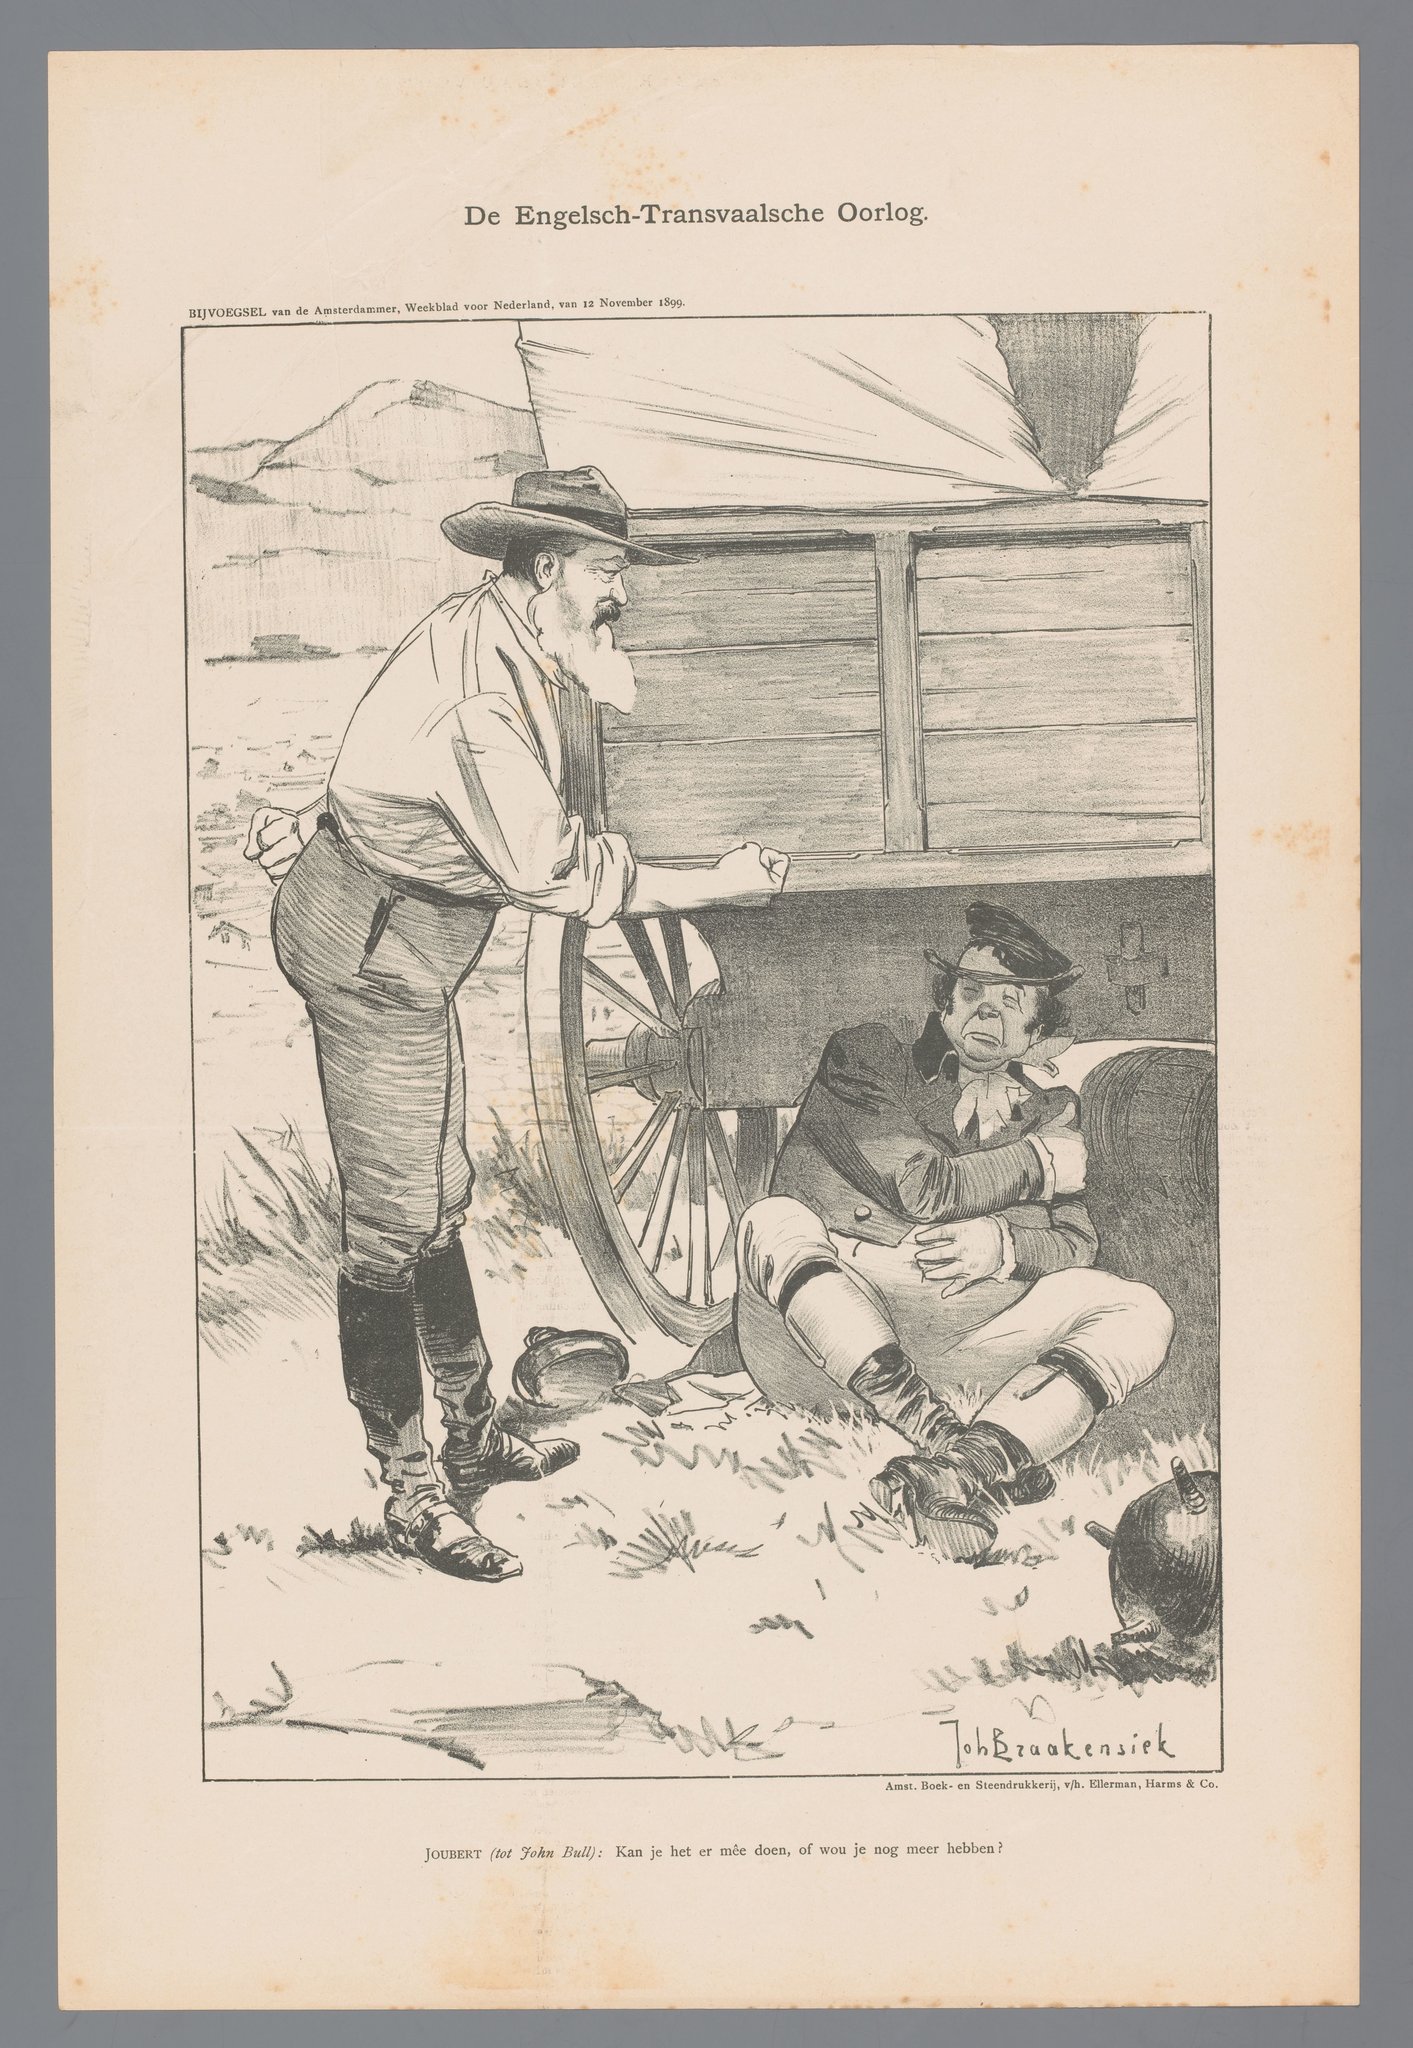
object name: cartoon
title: De Engelsch-Transvaalsche Oorlog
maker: johan braakensiek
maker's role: draughtsman, print maker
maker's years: 1858-1940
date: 1899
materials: paper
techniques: lithograph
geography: amsterdam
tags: politician, personifications of countries, nations, states, districts, etc., historical persons, political caricatures and satires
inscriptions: date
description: Prent uit het bijvoegsel van: De Amsterdammer. Weekblad voor Nederland, 12 november 1899.